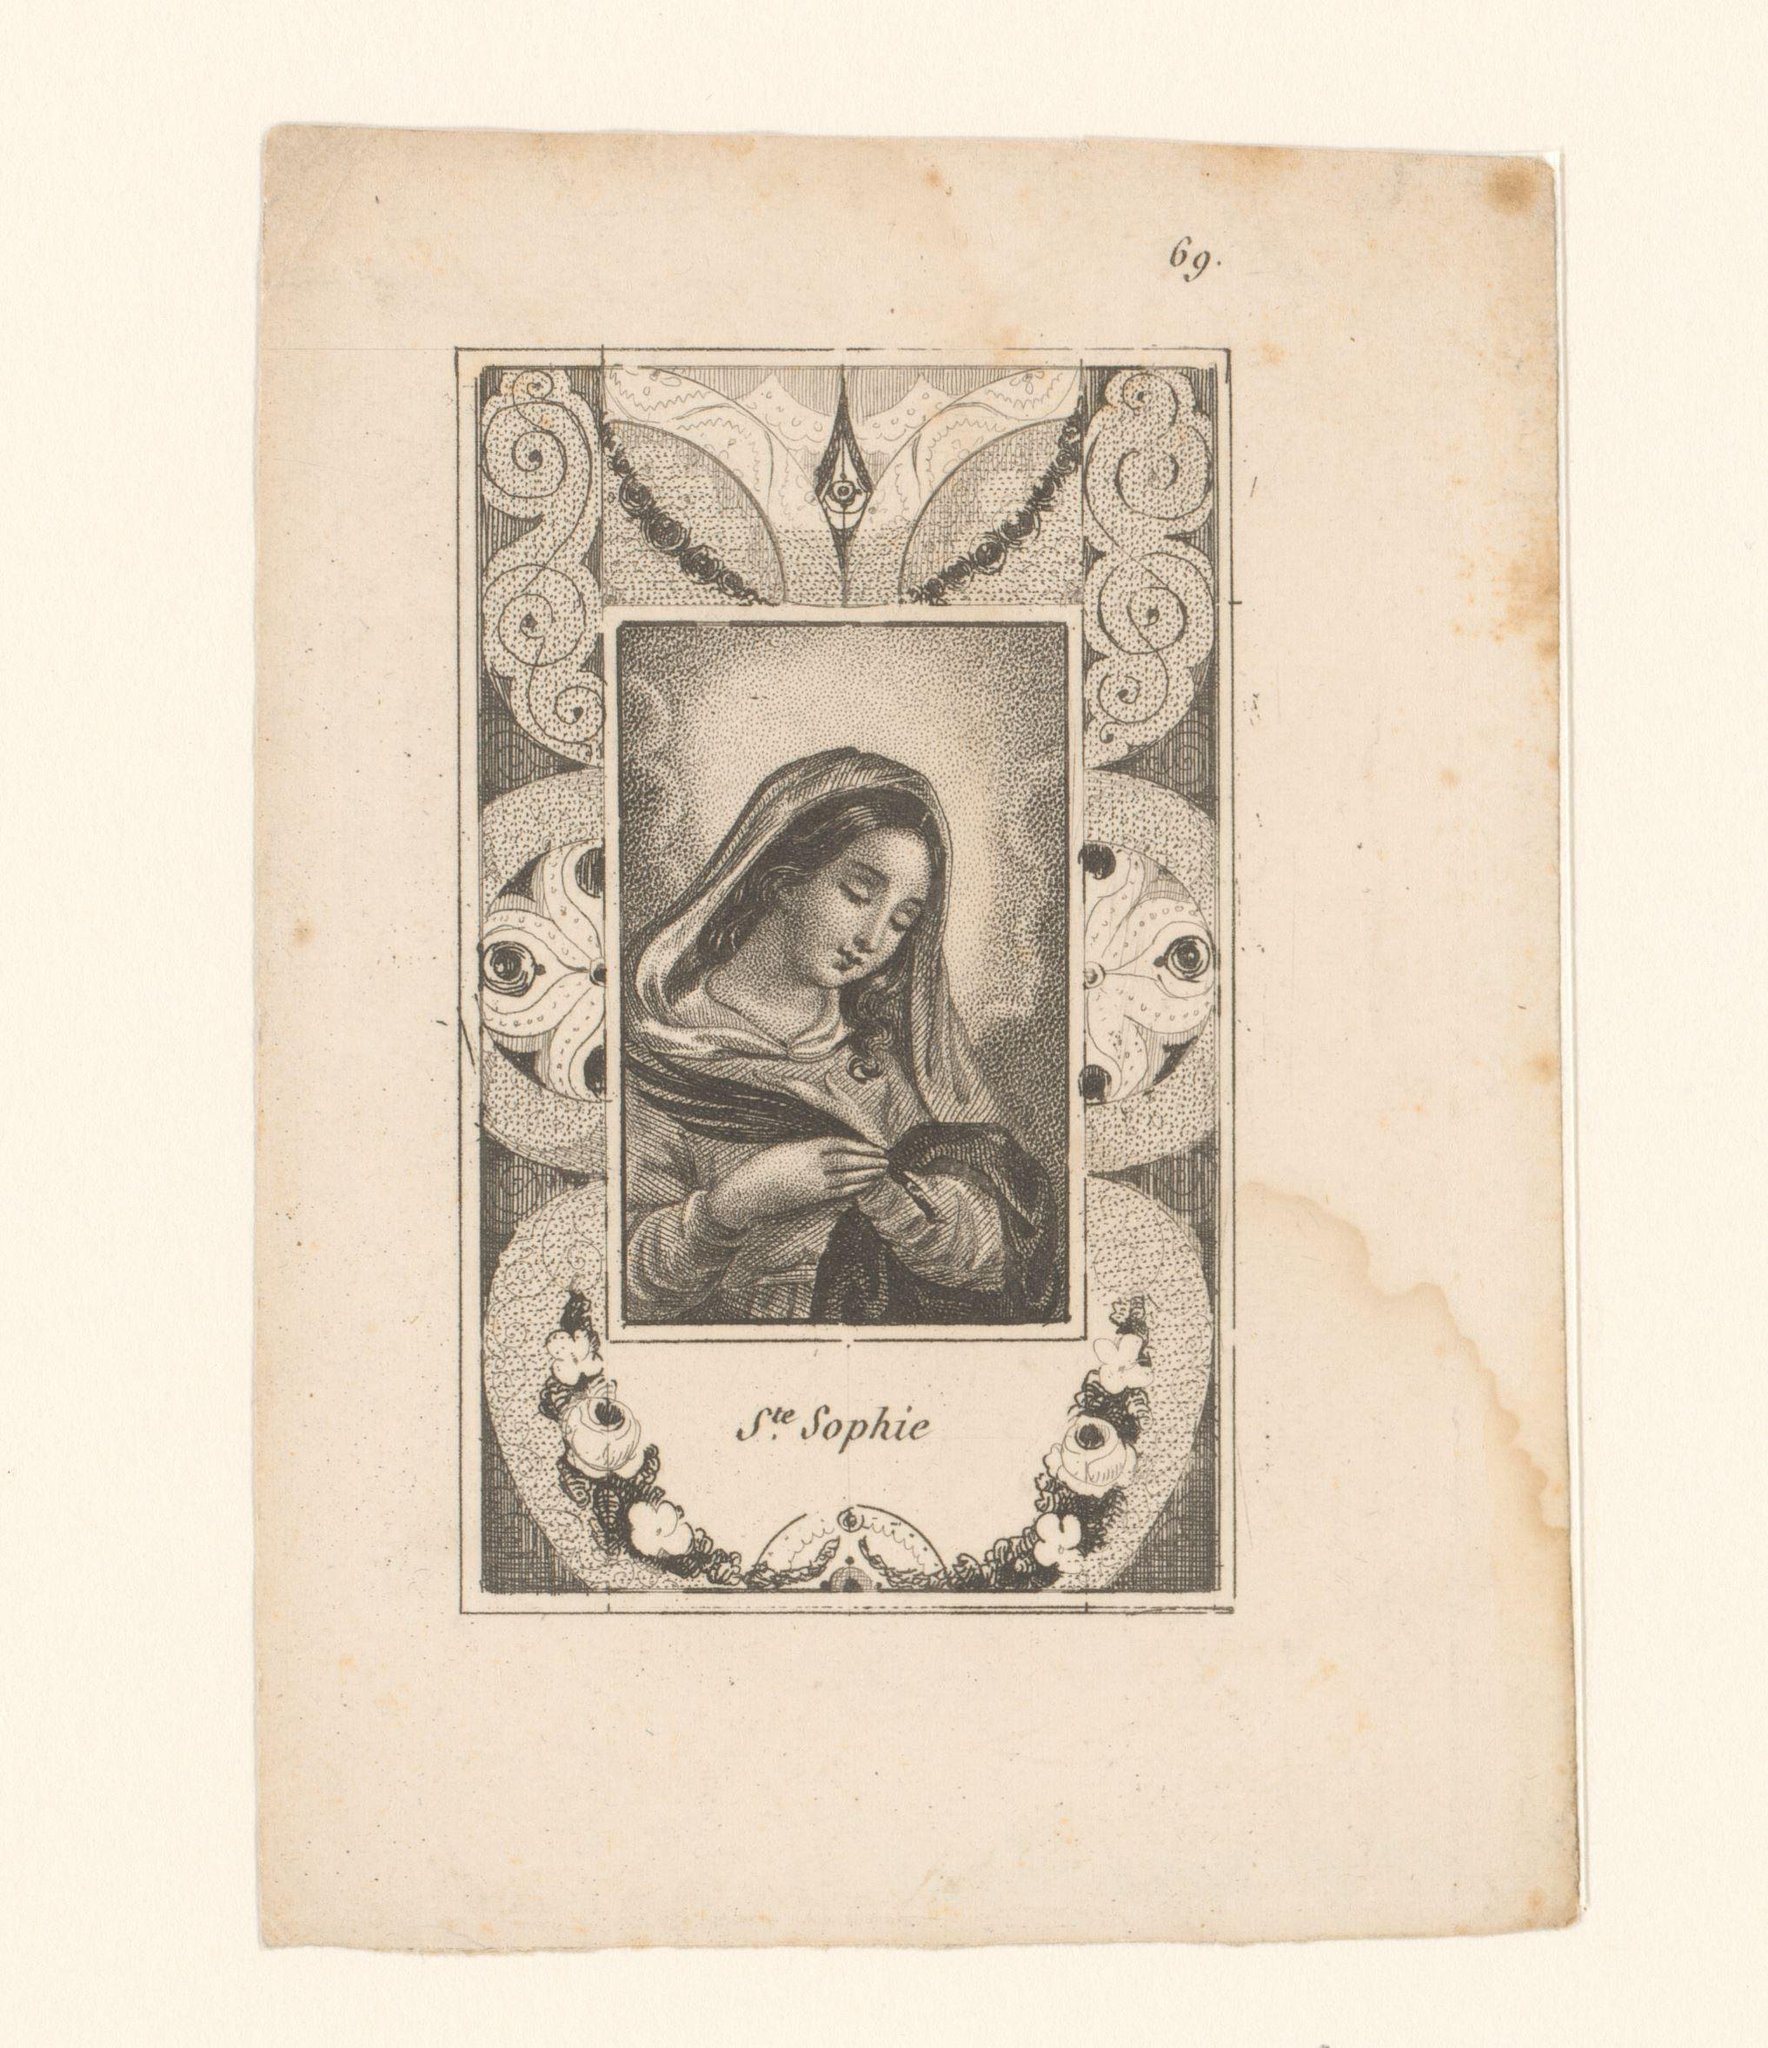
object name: print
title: H. Sophia van Rome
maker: Anonymous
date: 1700-1799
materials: paper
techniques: etching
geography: italy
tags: female saints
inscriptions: collector's mark: Lugt 2228